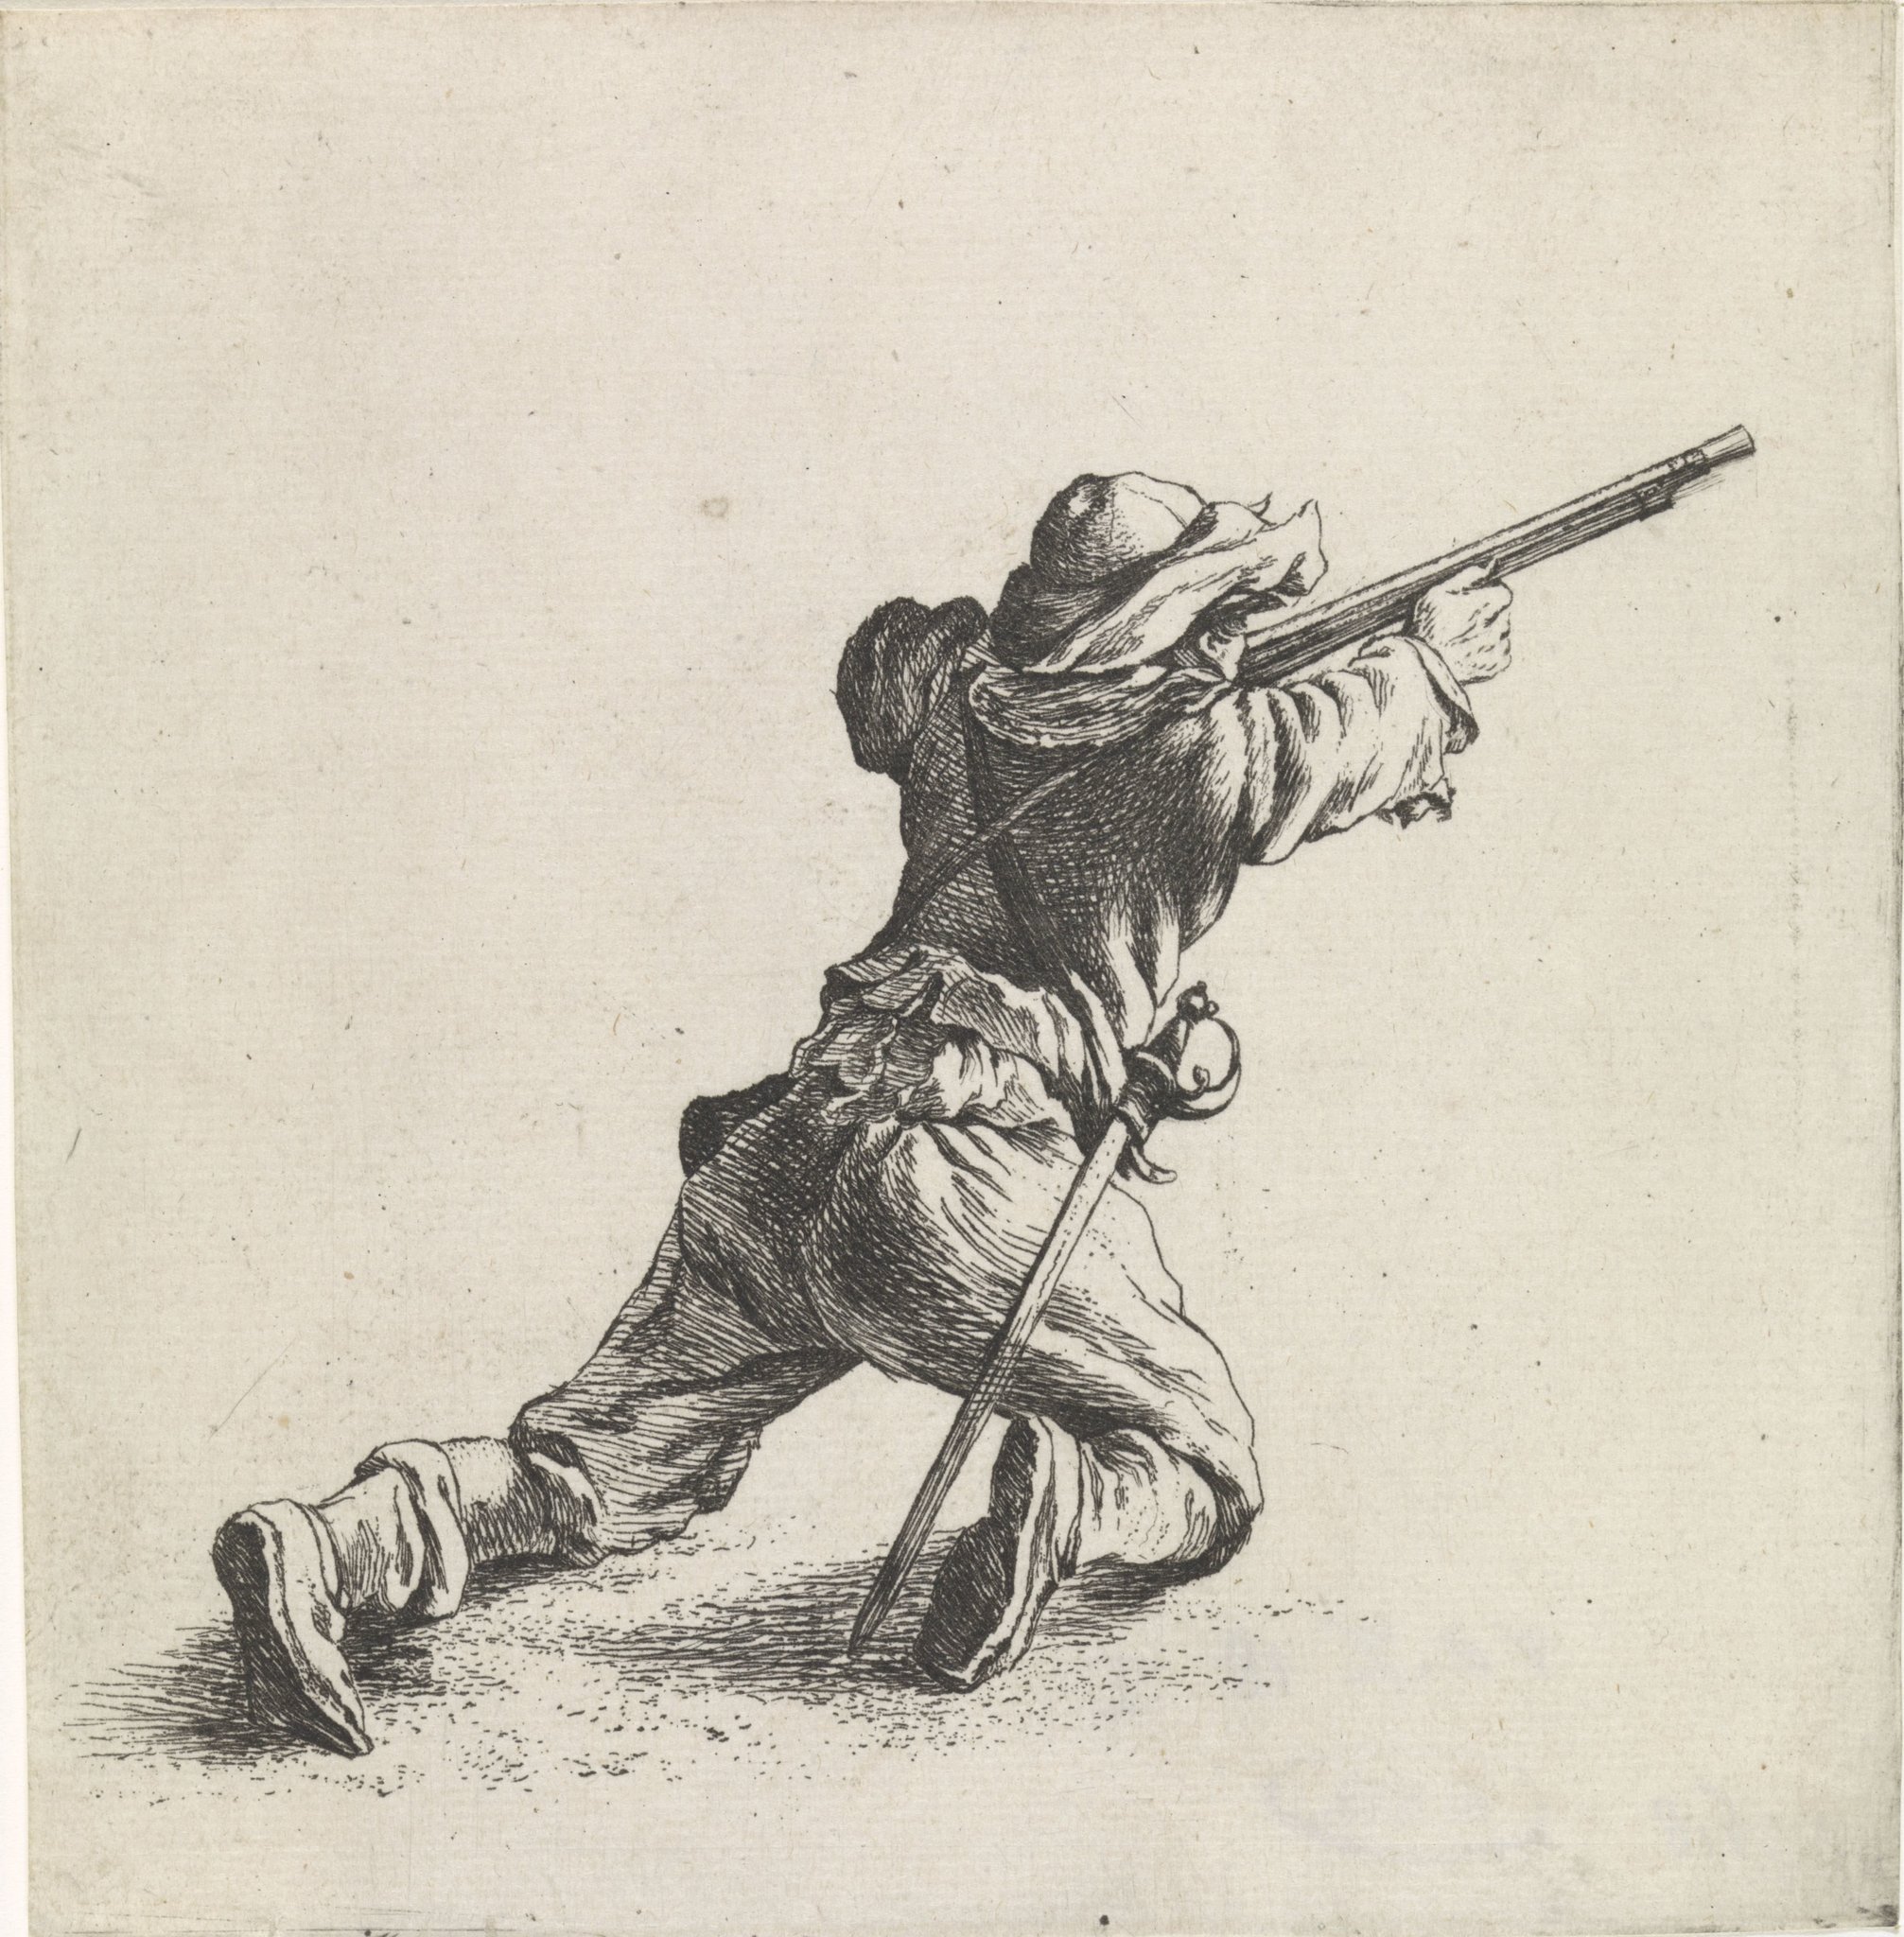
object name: print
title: Soldaat met geweer naar rechts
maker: dirk maas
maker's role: draughtsman, print maker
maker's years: 1659-1717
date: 1708-1717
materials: paper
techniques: etching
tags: the soldier; the soldier's life (+ weapons), handling of weapons ~ military training, firearms: rifle, kneeling on both knees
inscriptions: collector's mark: Lugt 2228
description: Geknielde soldaat met geweer naar rechts, op de rug gezien. Op zijn heup een zwaard. Vierde prent uit een serie van twaalf prenten met voorstellingen van soldaten en paarden.